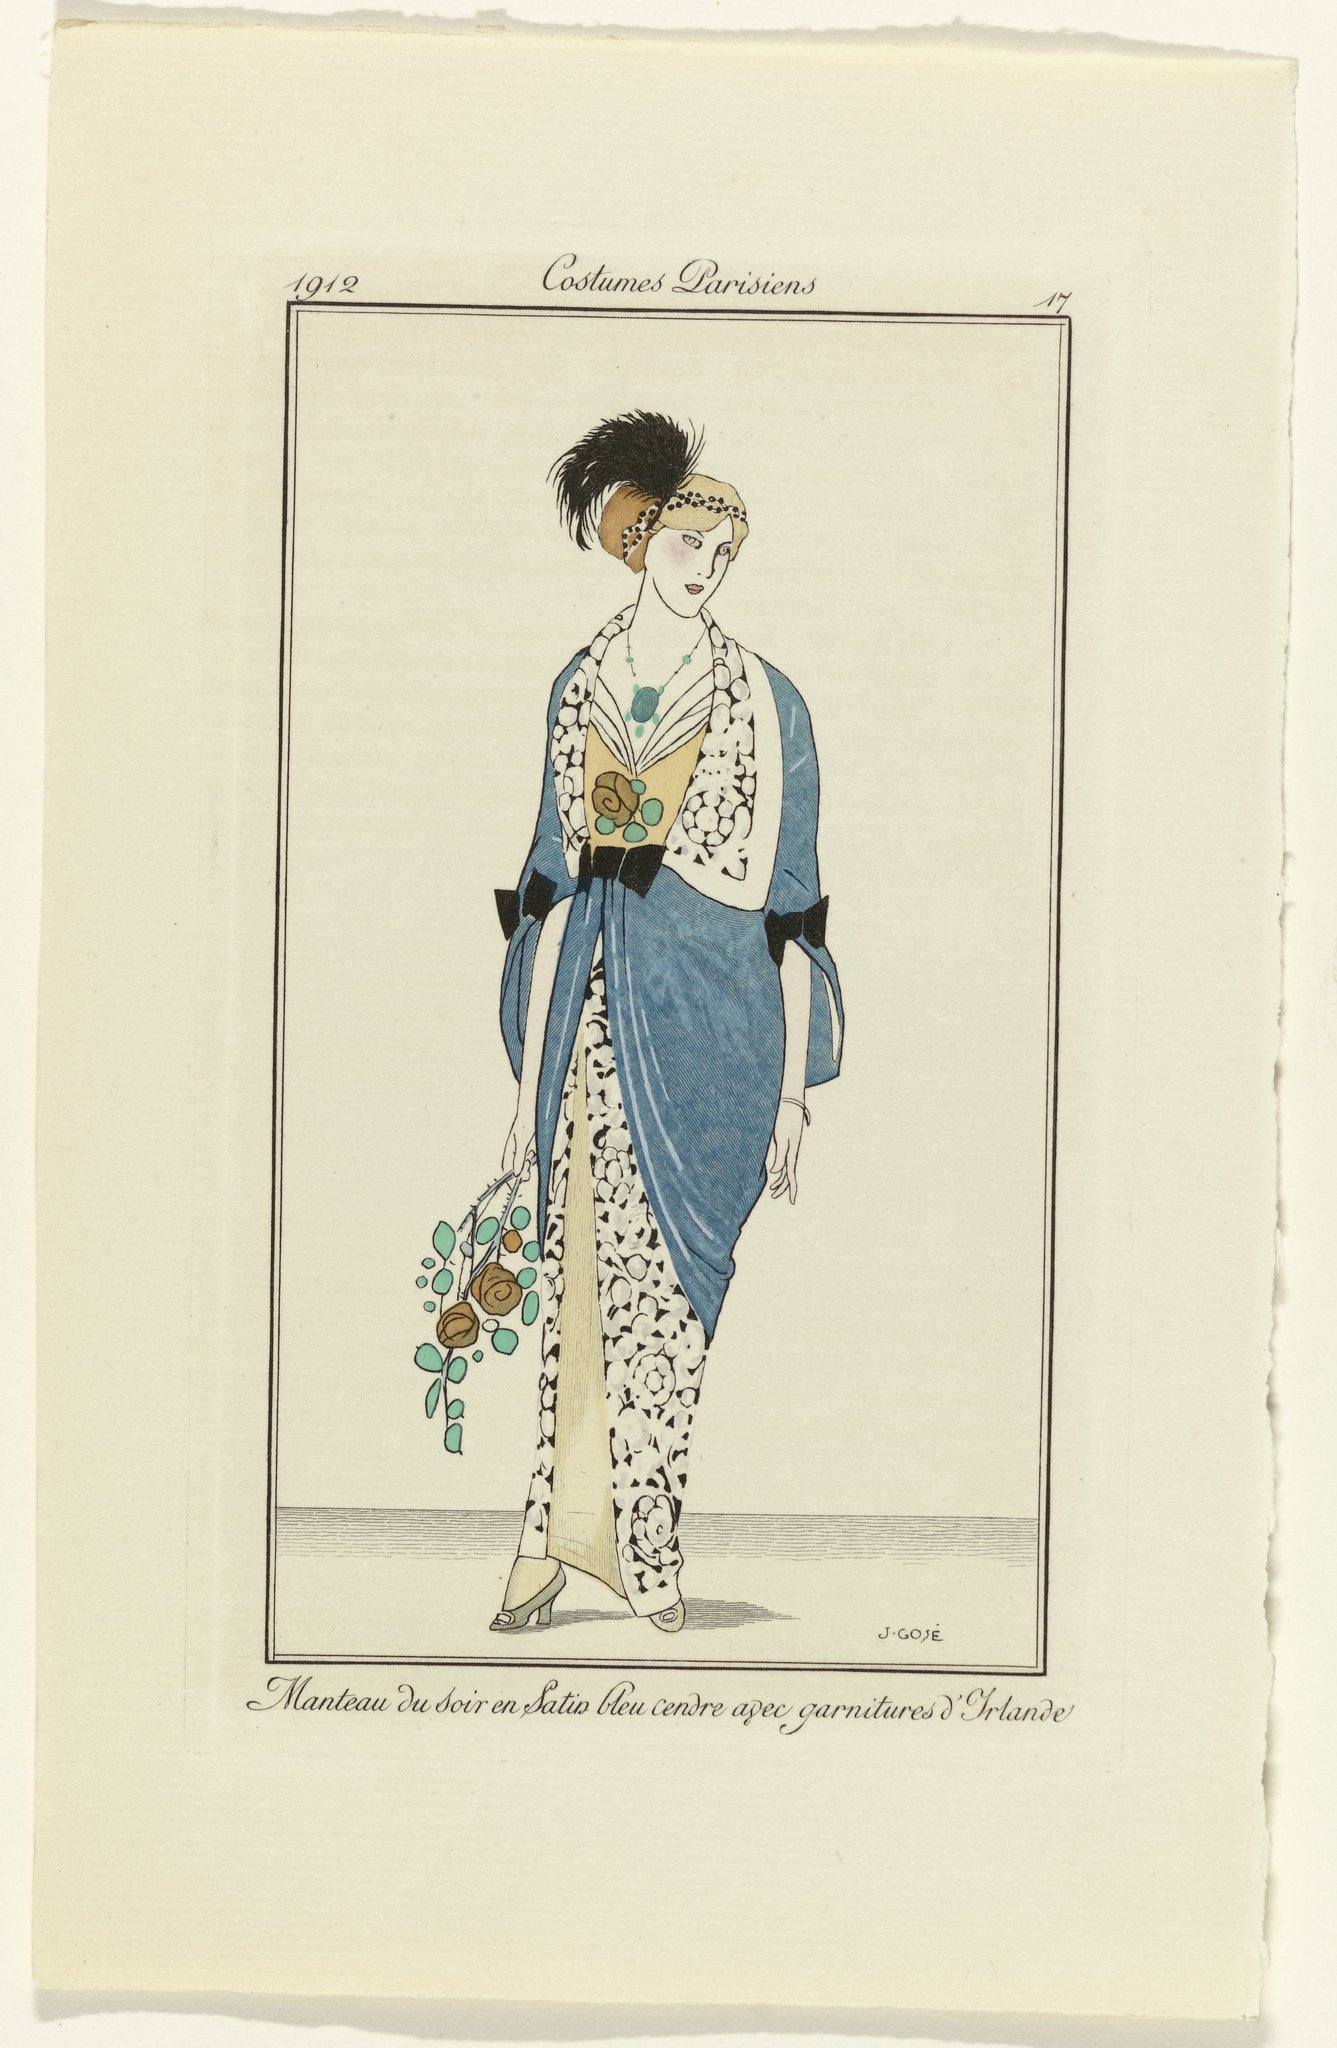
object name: fashion print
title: Journal des Dames et des Modes, 1912, Costumes Parisiens, no. 17: Manteau du soir en Satin bleu (...)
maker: francisco javier gosé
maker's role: draughtsman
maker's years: 1876-1915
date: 1912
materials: paper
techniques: engraving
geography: paris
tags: fashion plates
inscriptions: caption: ‘Robe de promenade en Sarah à damiers et taffetas peint à la main, bordée de velours noir: Chapeau de paille orné d'un panache en duvet de Cygne’